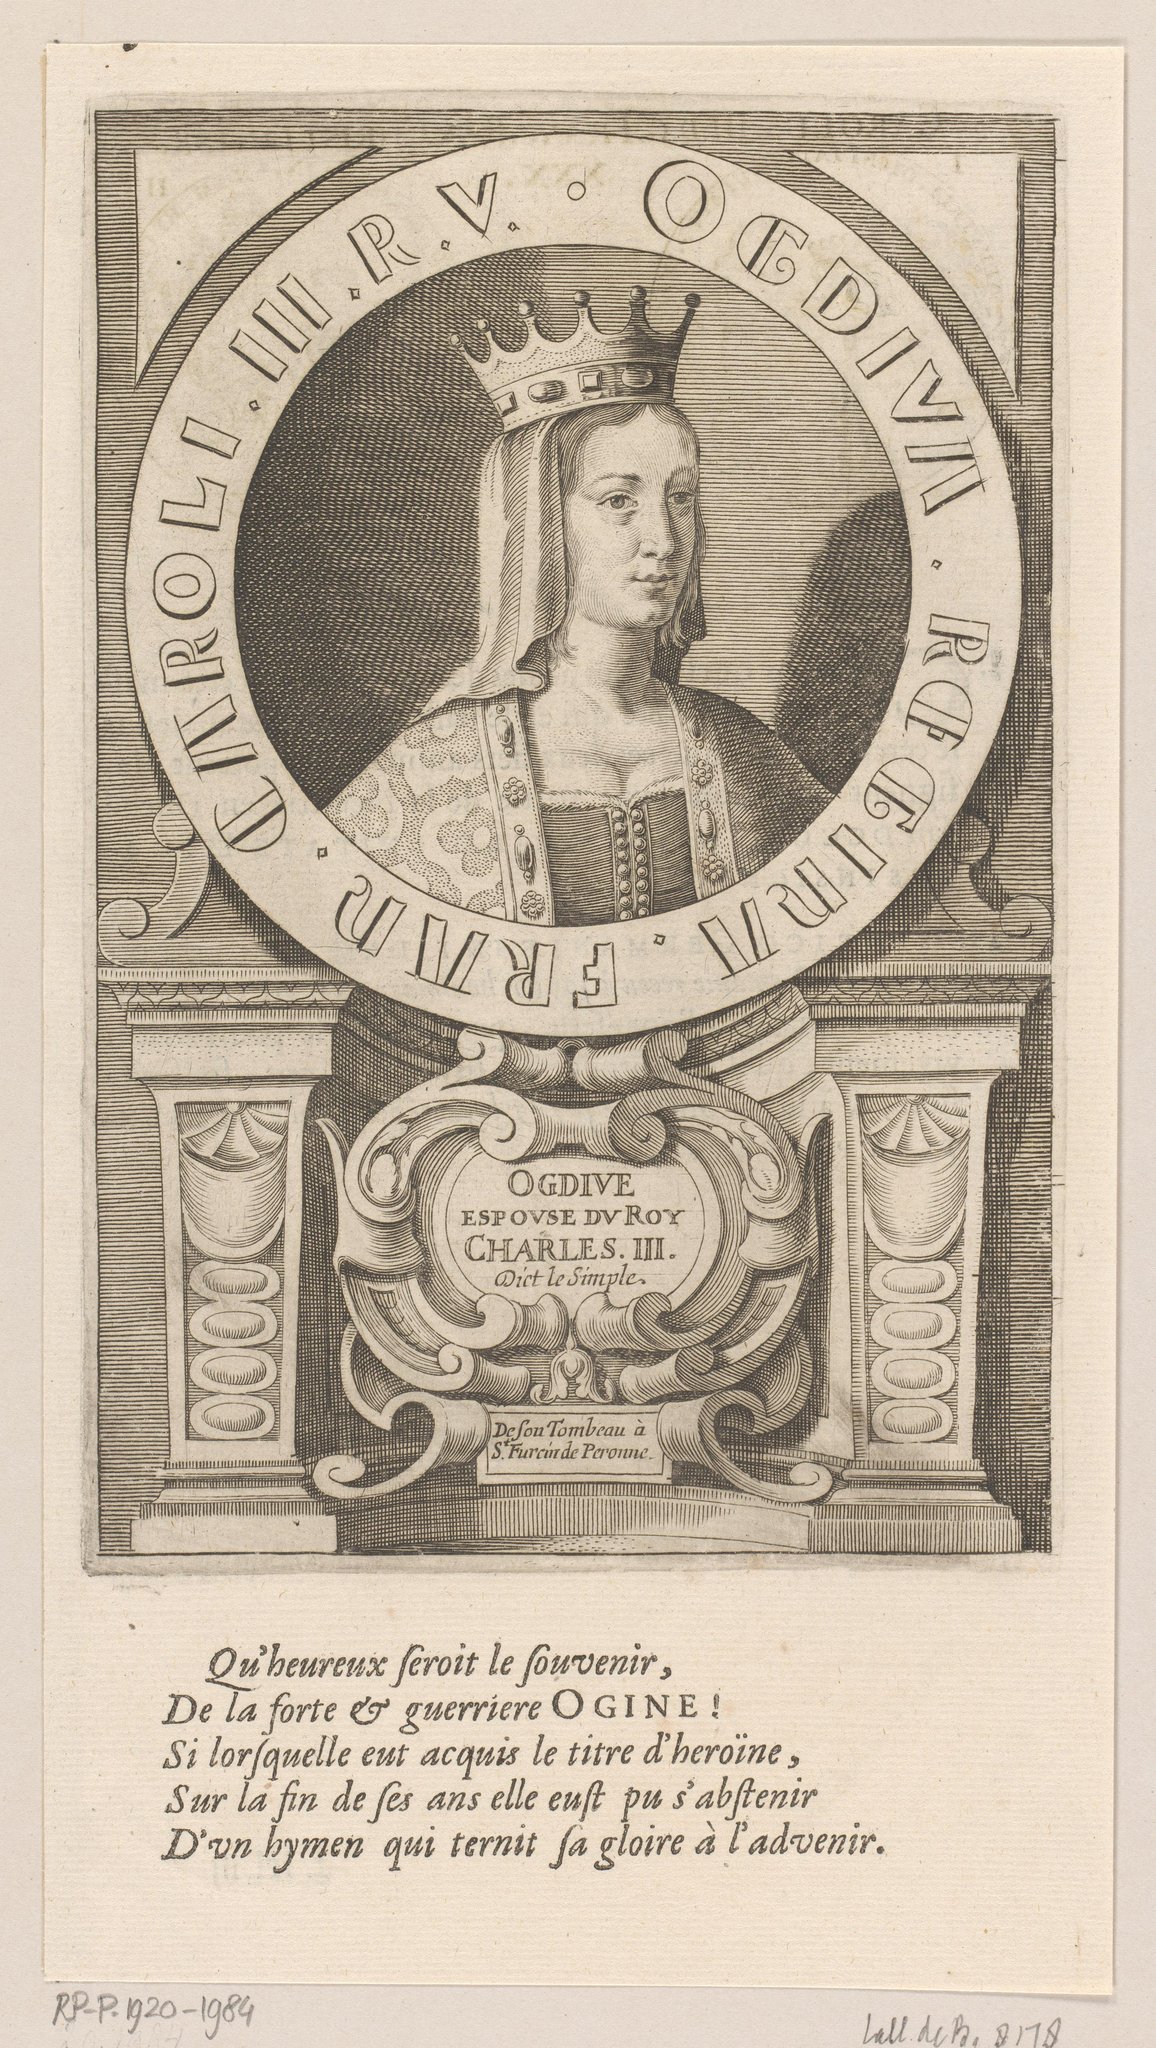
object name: print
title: Ogdive espouse du roy Charles III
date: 1635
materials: paper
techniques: engraving, letterpress printing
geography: paris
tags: historical persons, queen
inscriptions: collector's mark: Lugt 2228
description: Prent uit: Eudes de Mézeray, François. Histoire de France, depuis Faramond jusqu’au regne de Louis le Juste (...). 3 dln. Parijs: Denis Thierry, Jean Guignard en Claude Barbin, 1635, dl. 1. Prent waarschijnlijk voor het eerst verschenen in: Bie, Jacques de. Les vrais portraits des rois de France (...). Parijs: Jacques de Bie en Pierre Rocolet, 1634. Prent ook gebruikt in latere publicaties.